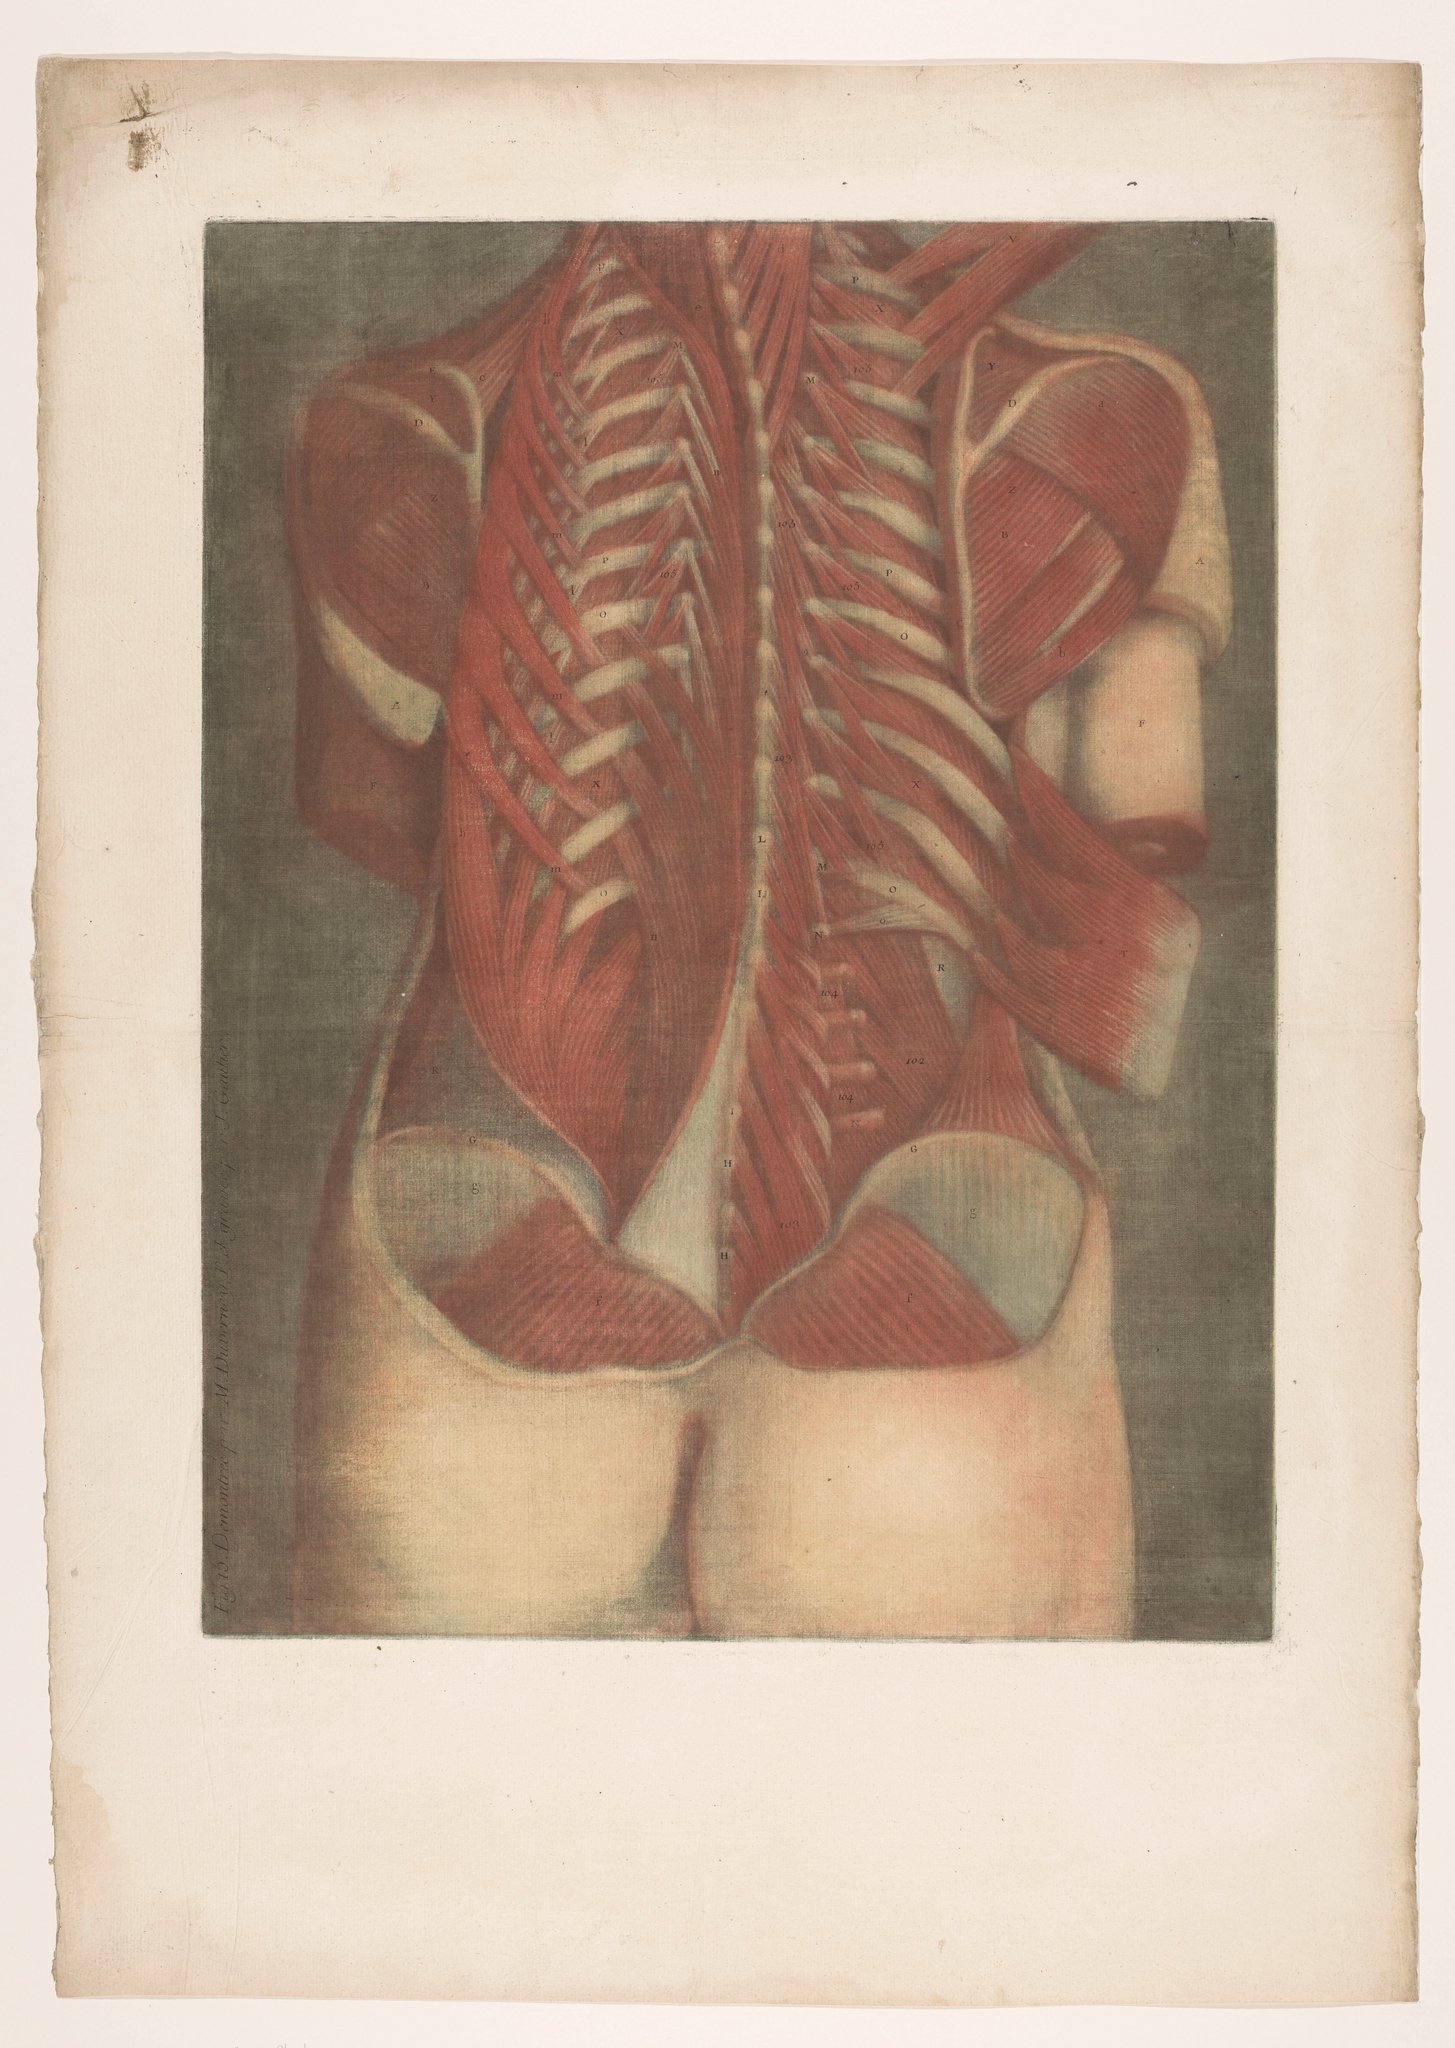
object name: print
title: Anatomisch spiermodel van een vrouwentorso, van achteren gezien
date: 1746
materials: paper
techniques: engraving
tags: anatomical model of the muscles, muscle-man, 'écorché'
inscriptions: collector's mark: Lugt 2760, collector's mark: Lugt 2228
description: Prent gebruikt in: Gautier d'Agoty, Jacques Fabien. Myologie complette en couleur et grandeur naturelle (...). Parijs: Jacques Fabien Gautier d'Agoty e.a., 1746, plaat 15.